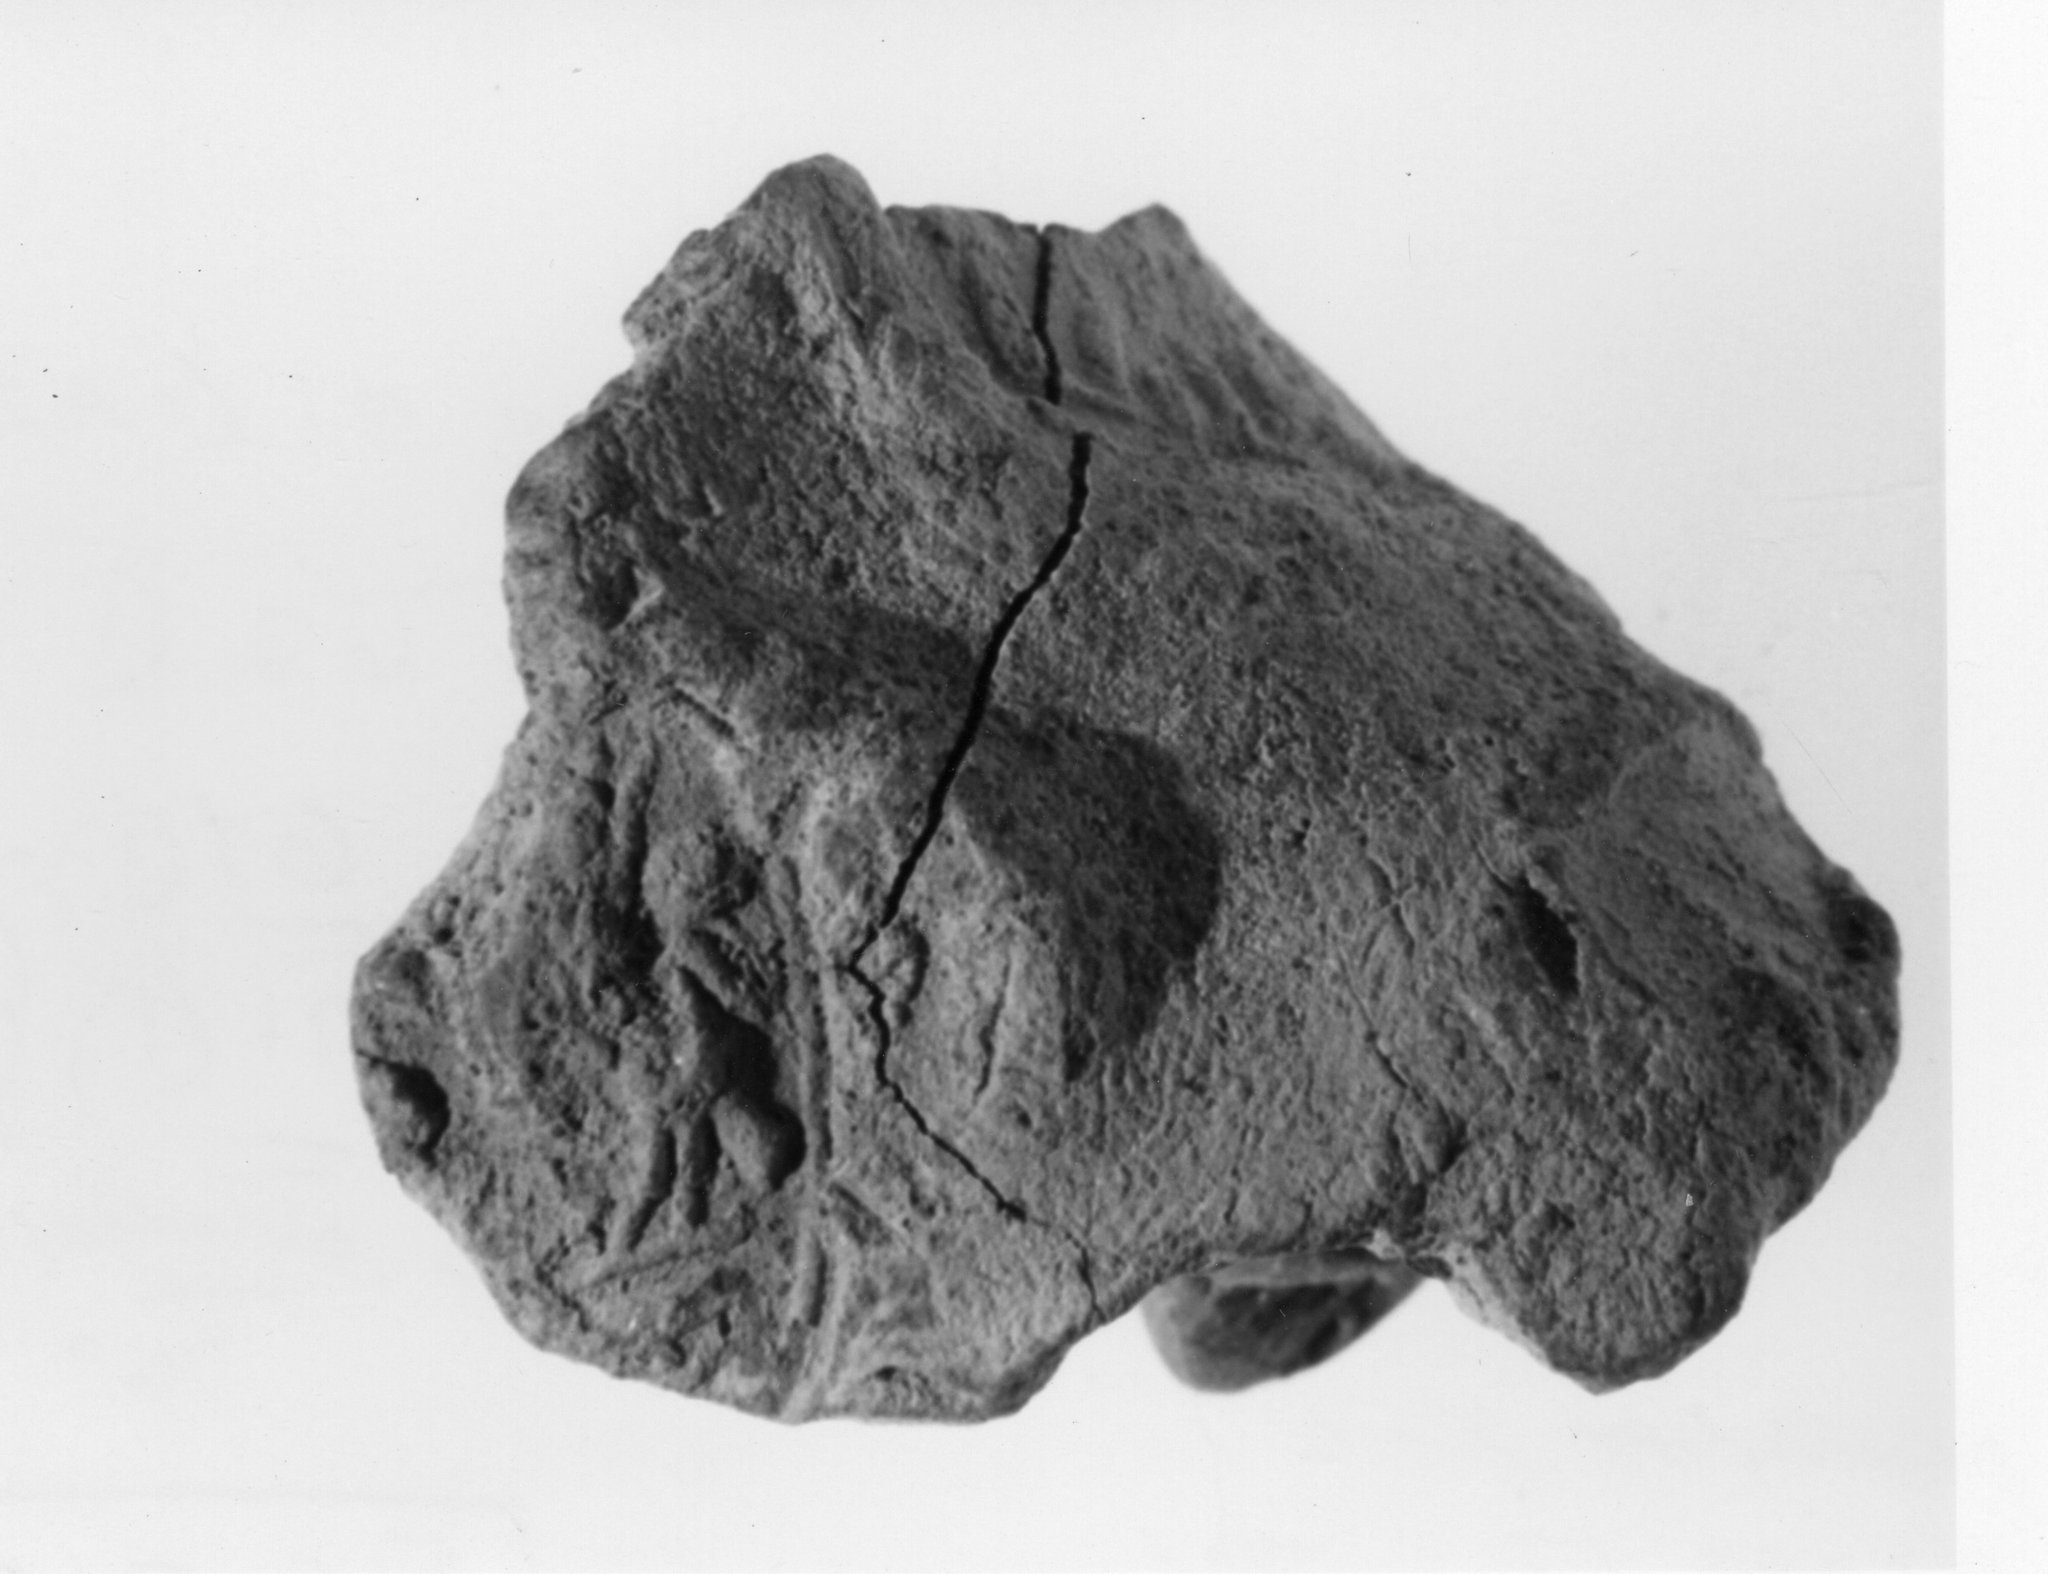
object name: sealing, amenhotep iii, nebmaatre, horus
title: Document Sealing With Multiple Seal Impressions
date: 1390-1352 BCE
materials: mud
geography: egypt